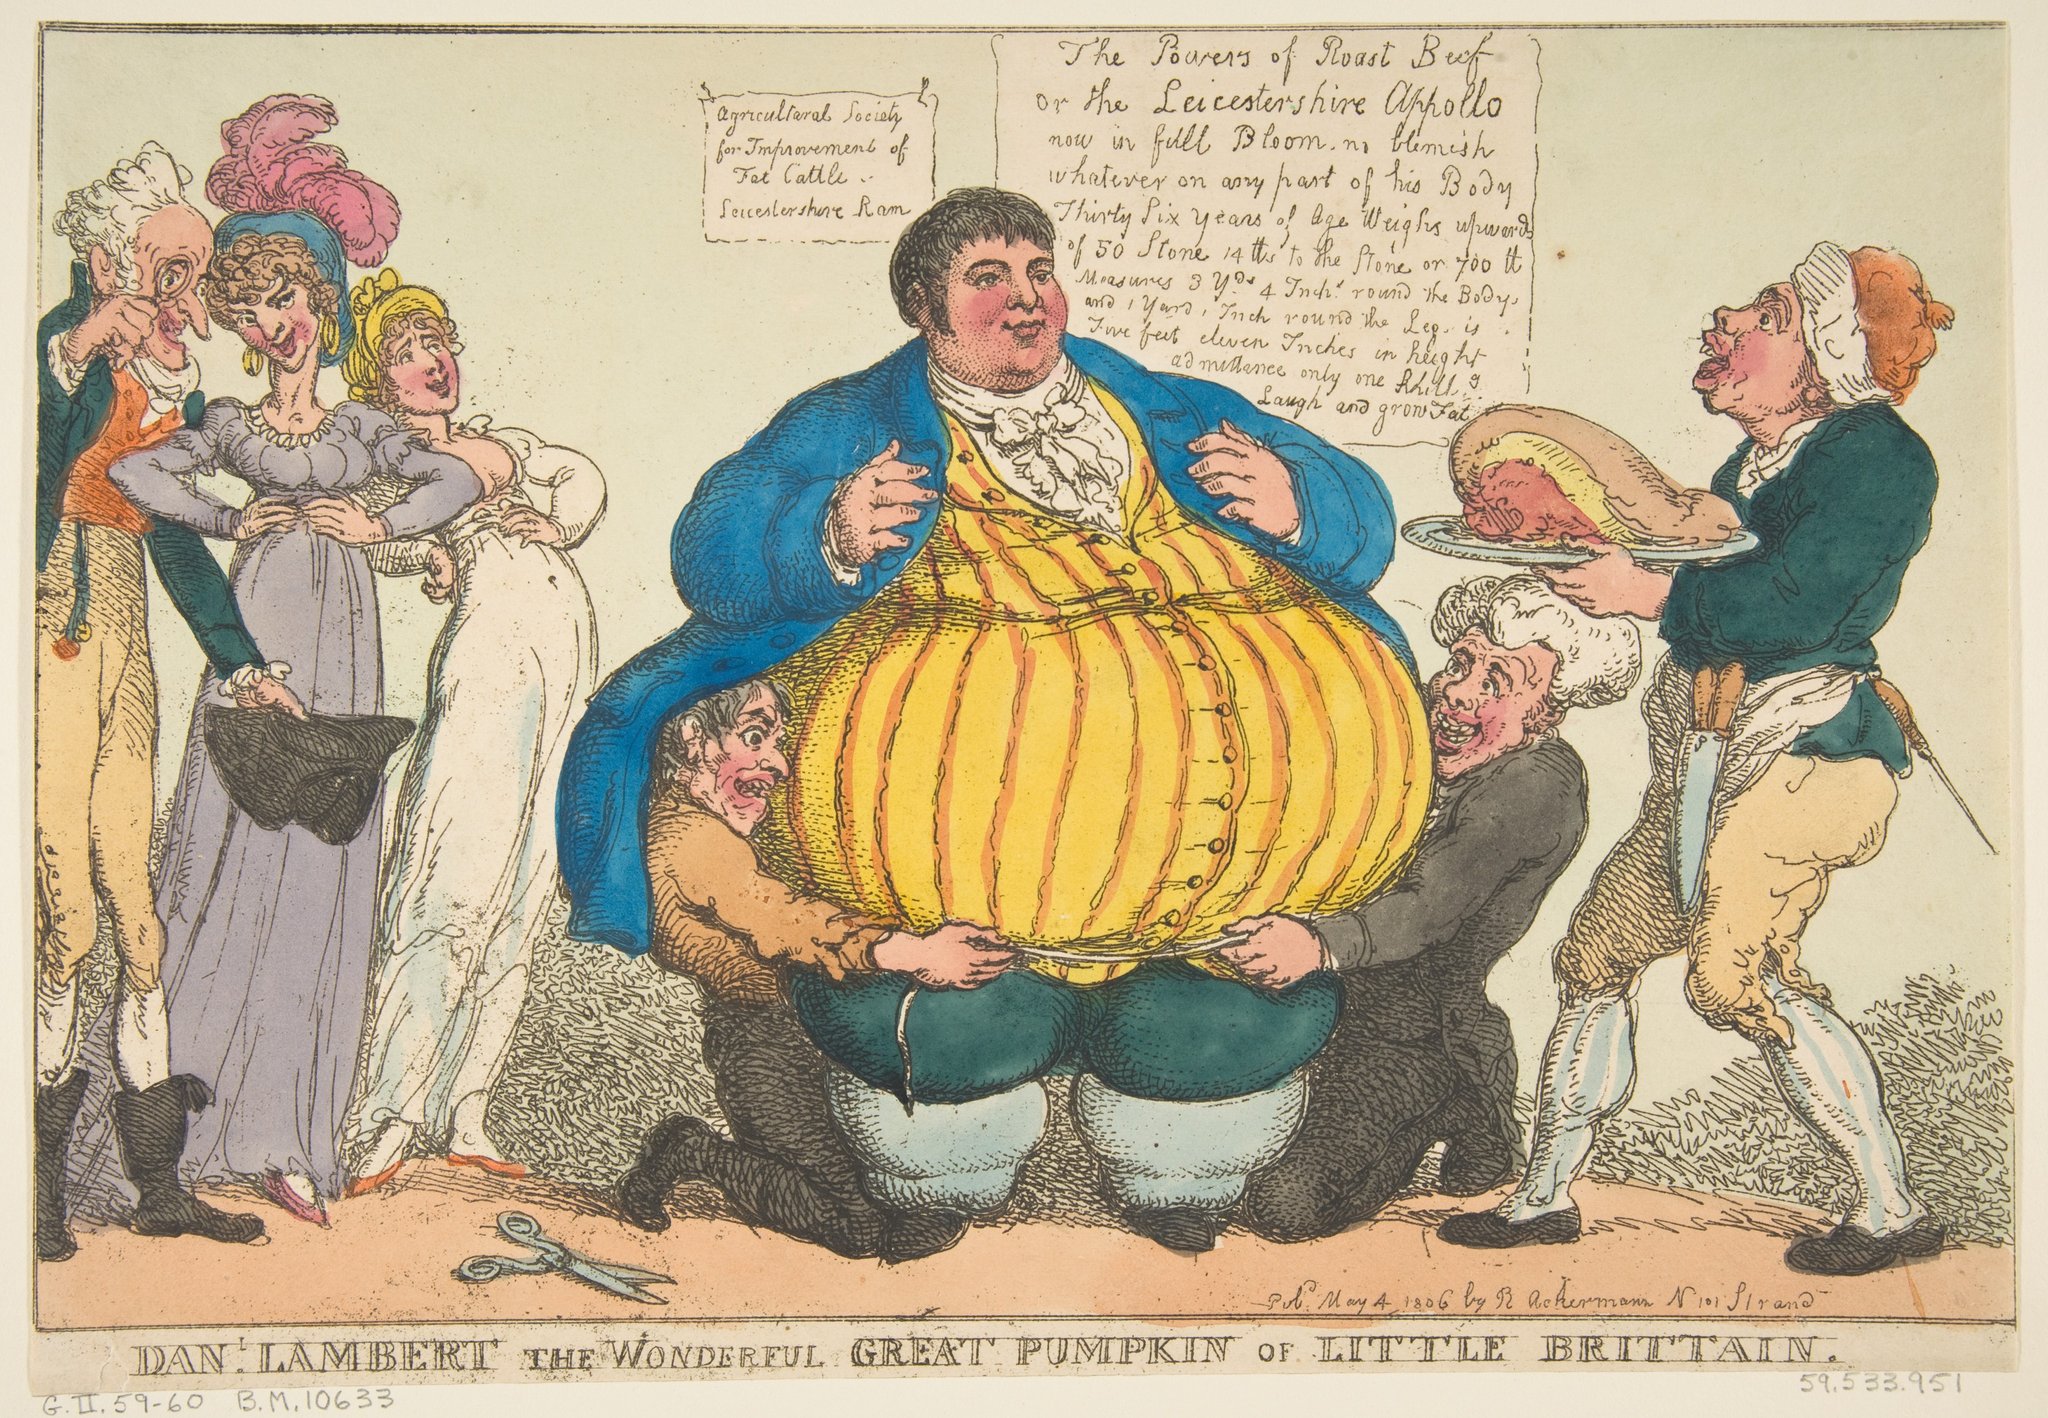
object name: print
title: Dan-l. Lambert the Wonderful Great Pumpkin of Little Brittain [sic]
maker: thomas rowlandson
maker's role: artist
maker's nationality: british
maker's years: 1757-1827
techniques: etching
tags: men,women